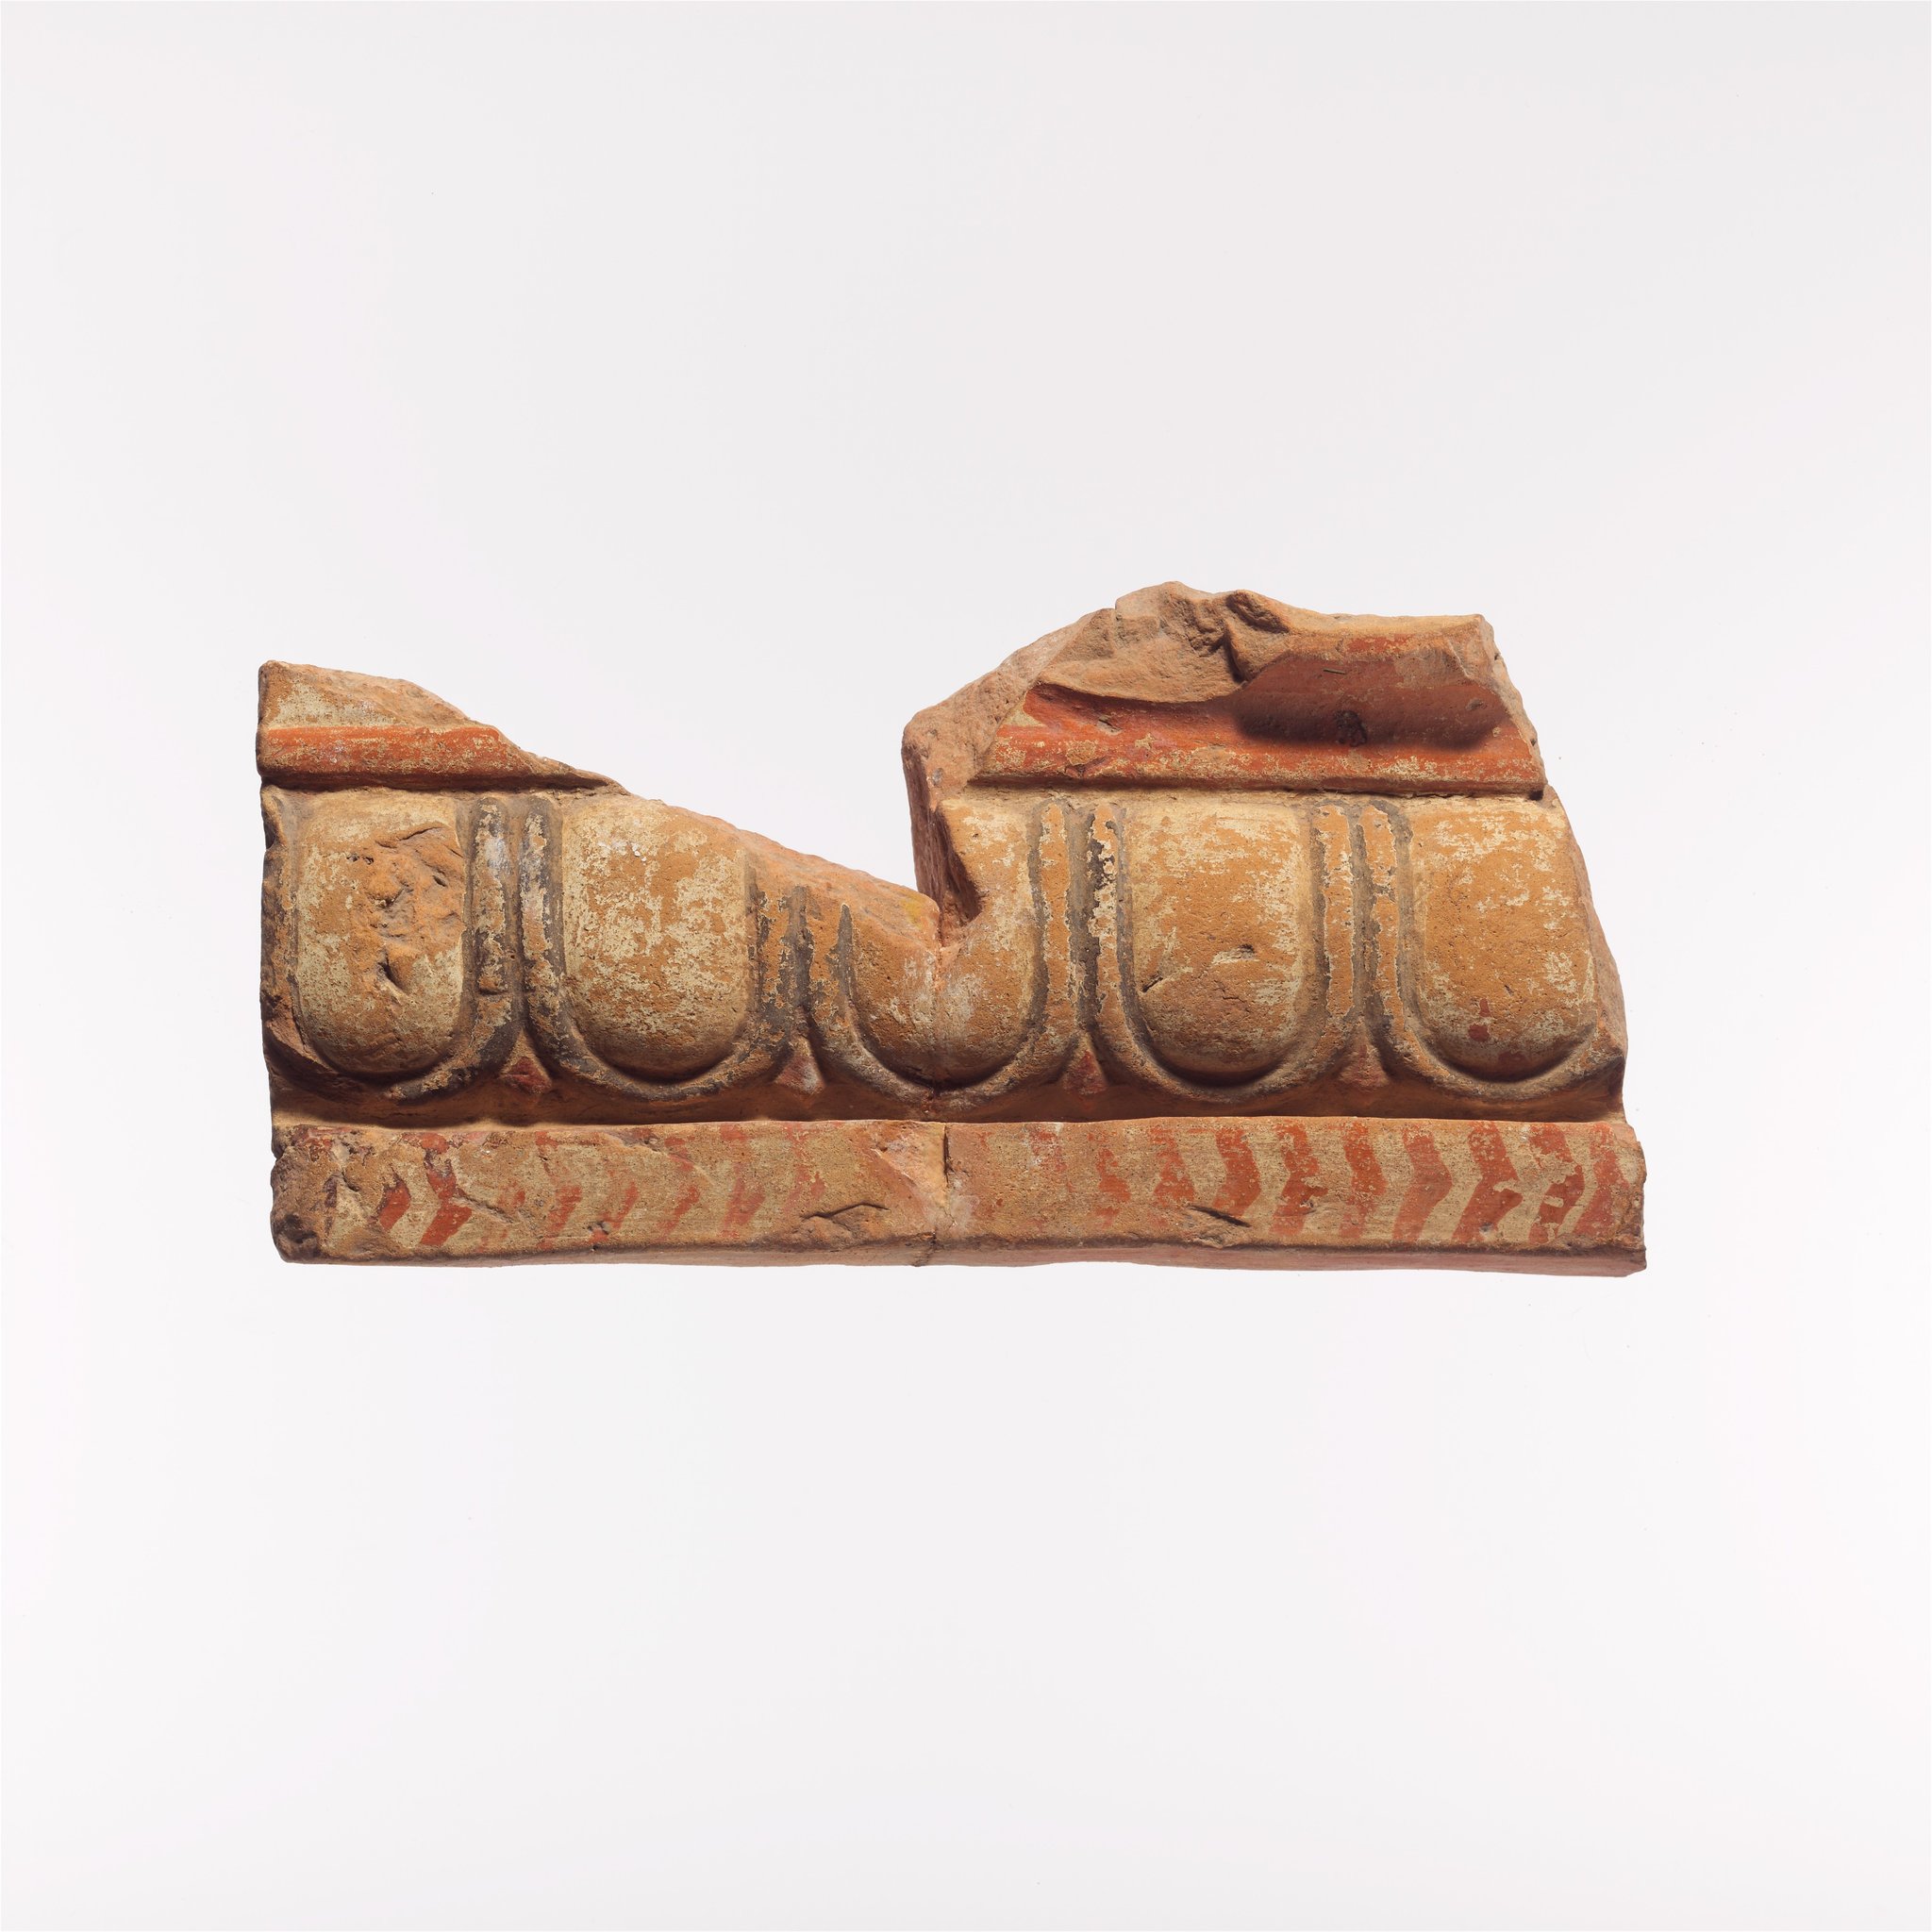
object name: tile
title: Fragment of a terracotta architectural tile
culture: lydian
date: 600-501 BCE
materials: terracotta